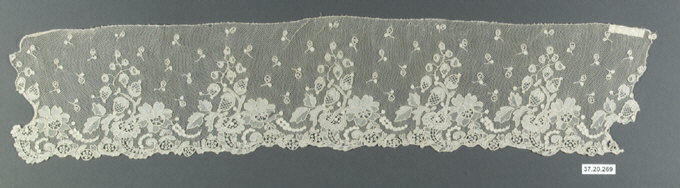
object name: border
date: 1801-1900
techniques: lace